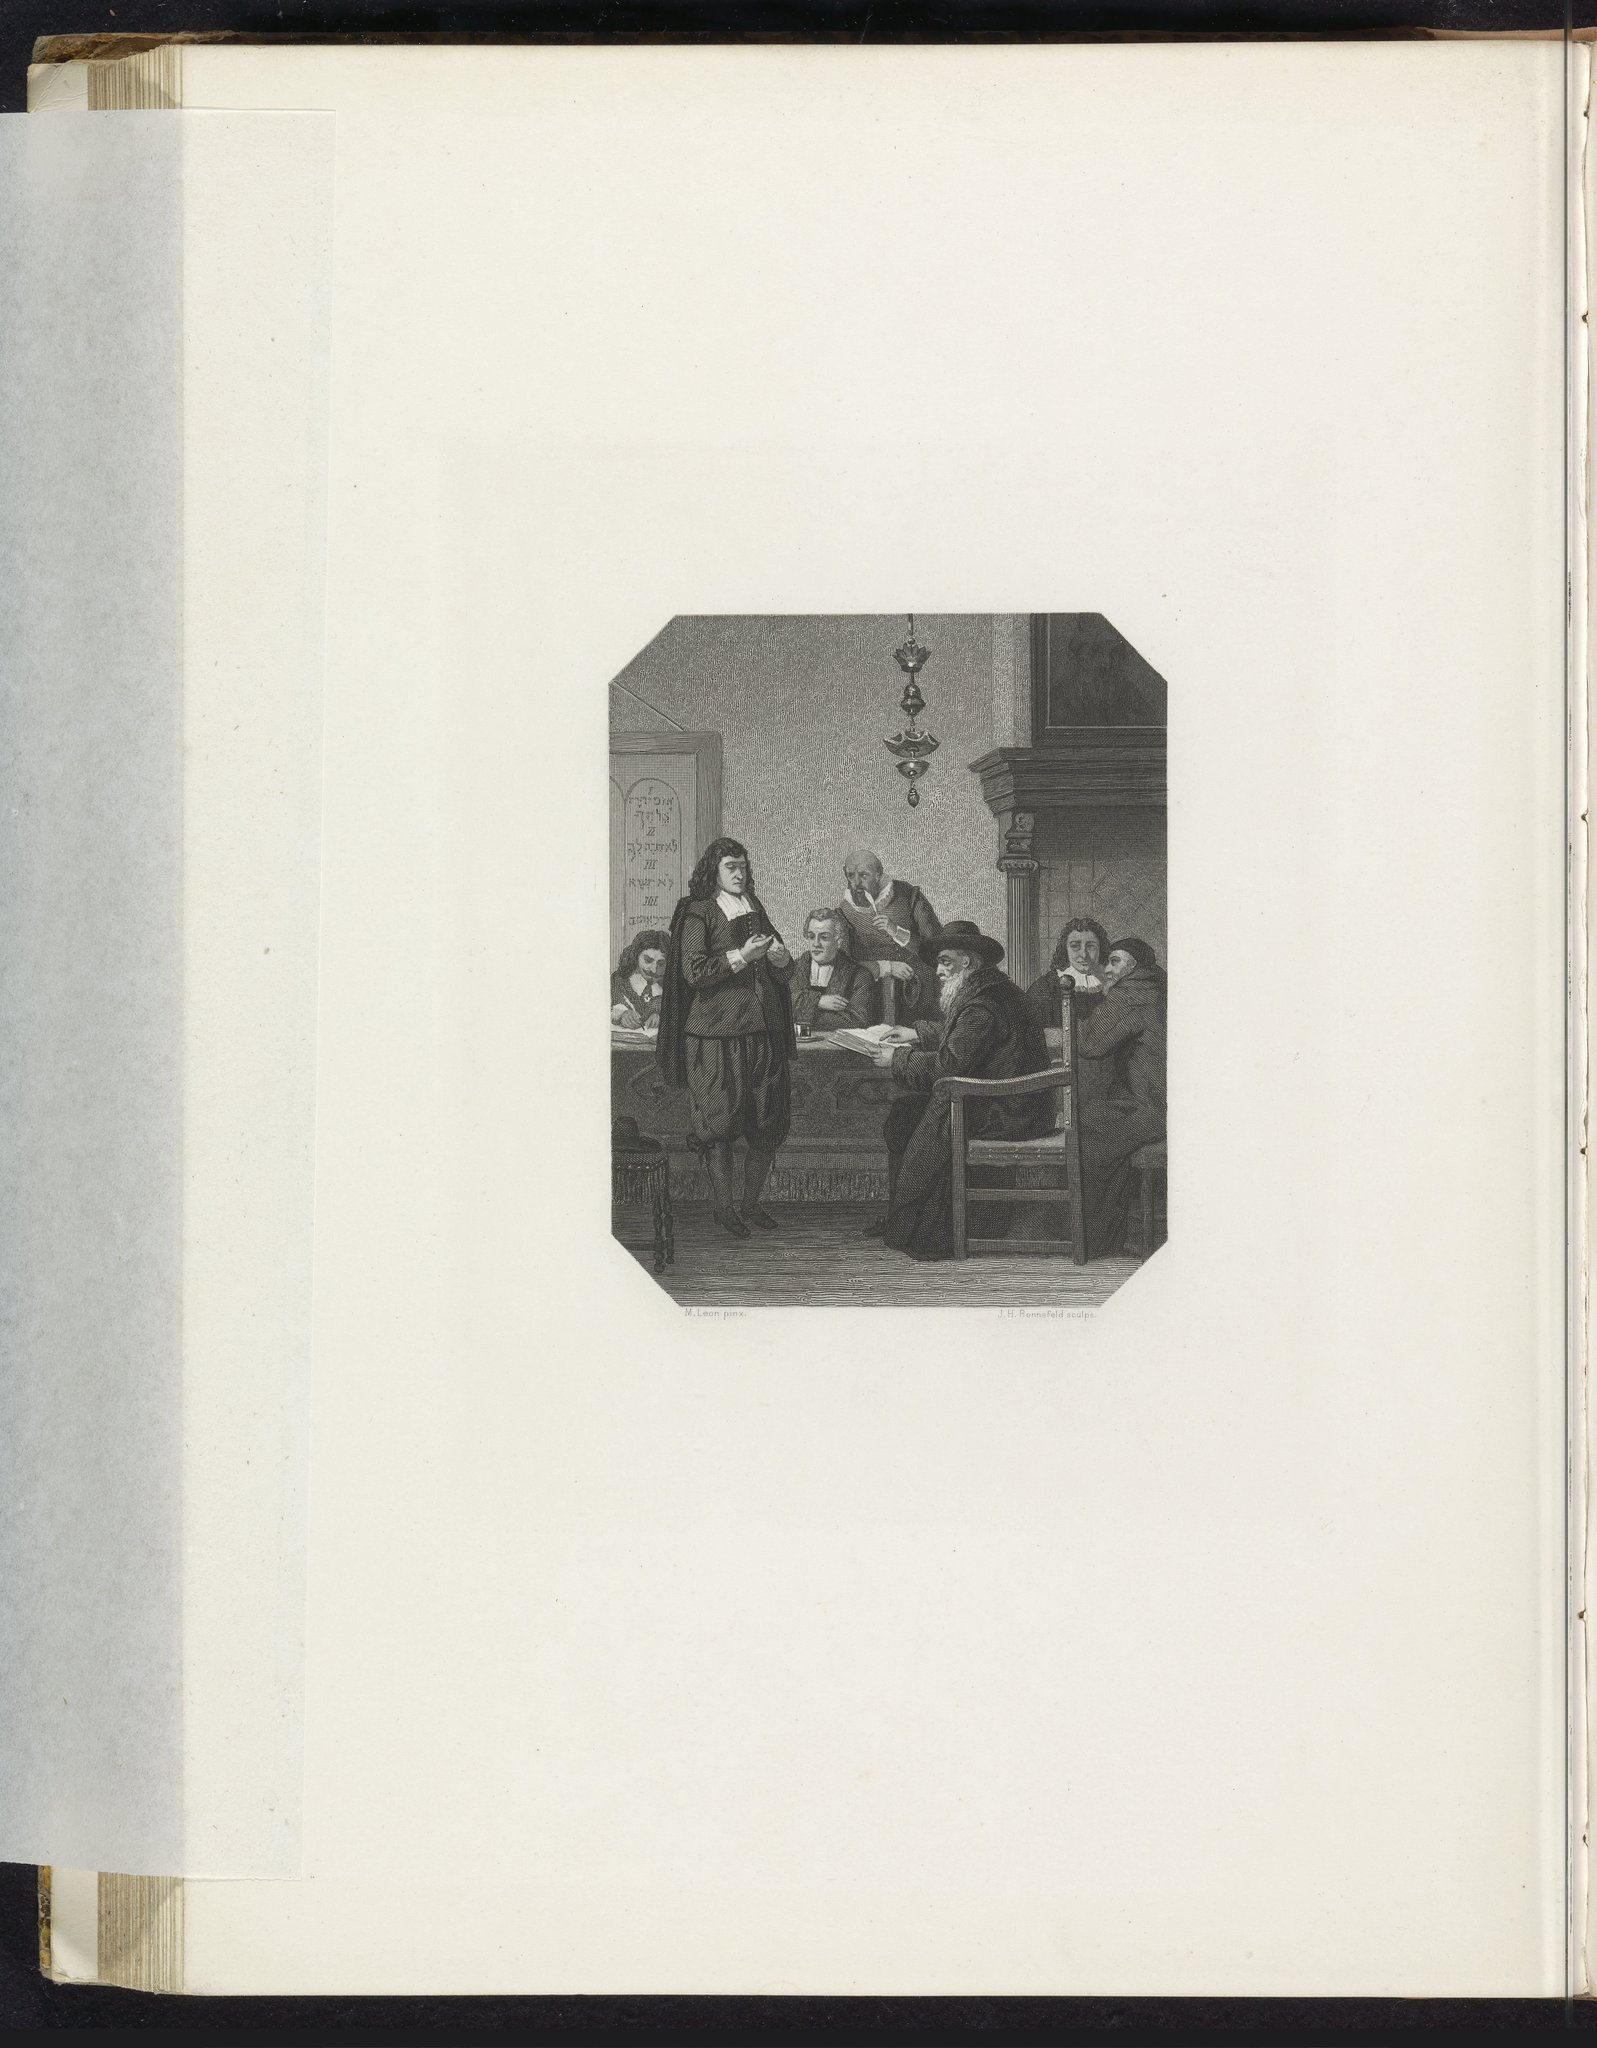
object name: print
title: Spinoza, ca. 1665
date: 1865-1870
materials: paper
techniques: engraving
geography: netherlands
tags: amsterdam, the hague, baruch de spinoza, scholar, philosopher, the synagogue (as building and place of worship ~ jewish religion)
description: Baruch de Spinoza in discussie met joodse schriftgeleerden in de synagoge, ca. 1665. Onderdeel van de groep staalgravures naar de schilderijen van de Historische Galerij der Maatschappij Arti et Amicitiae.